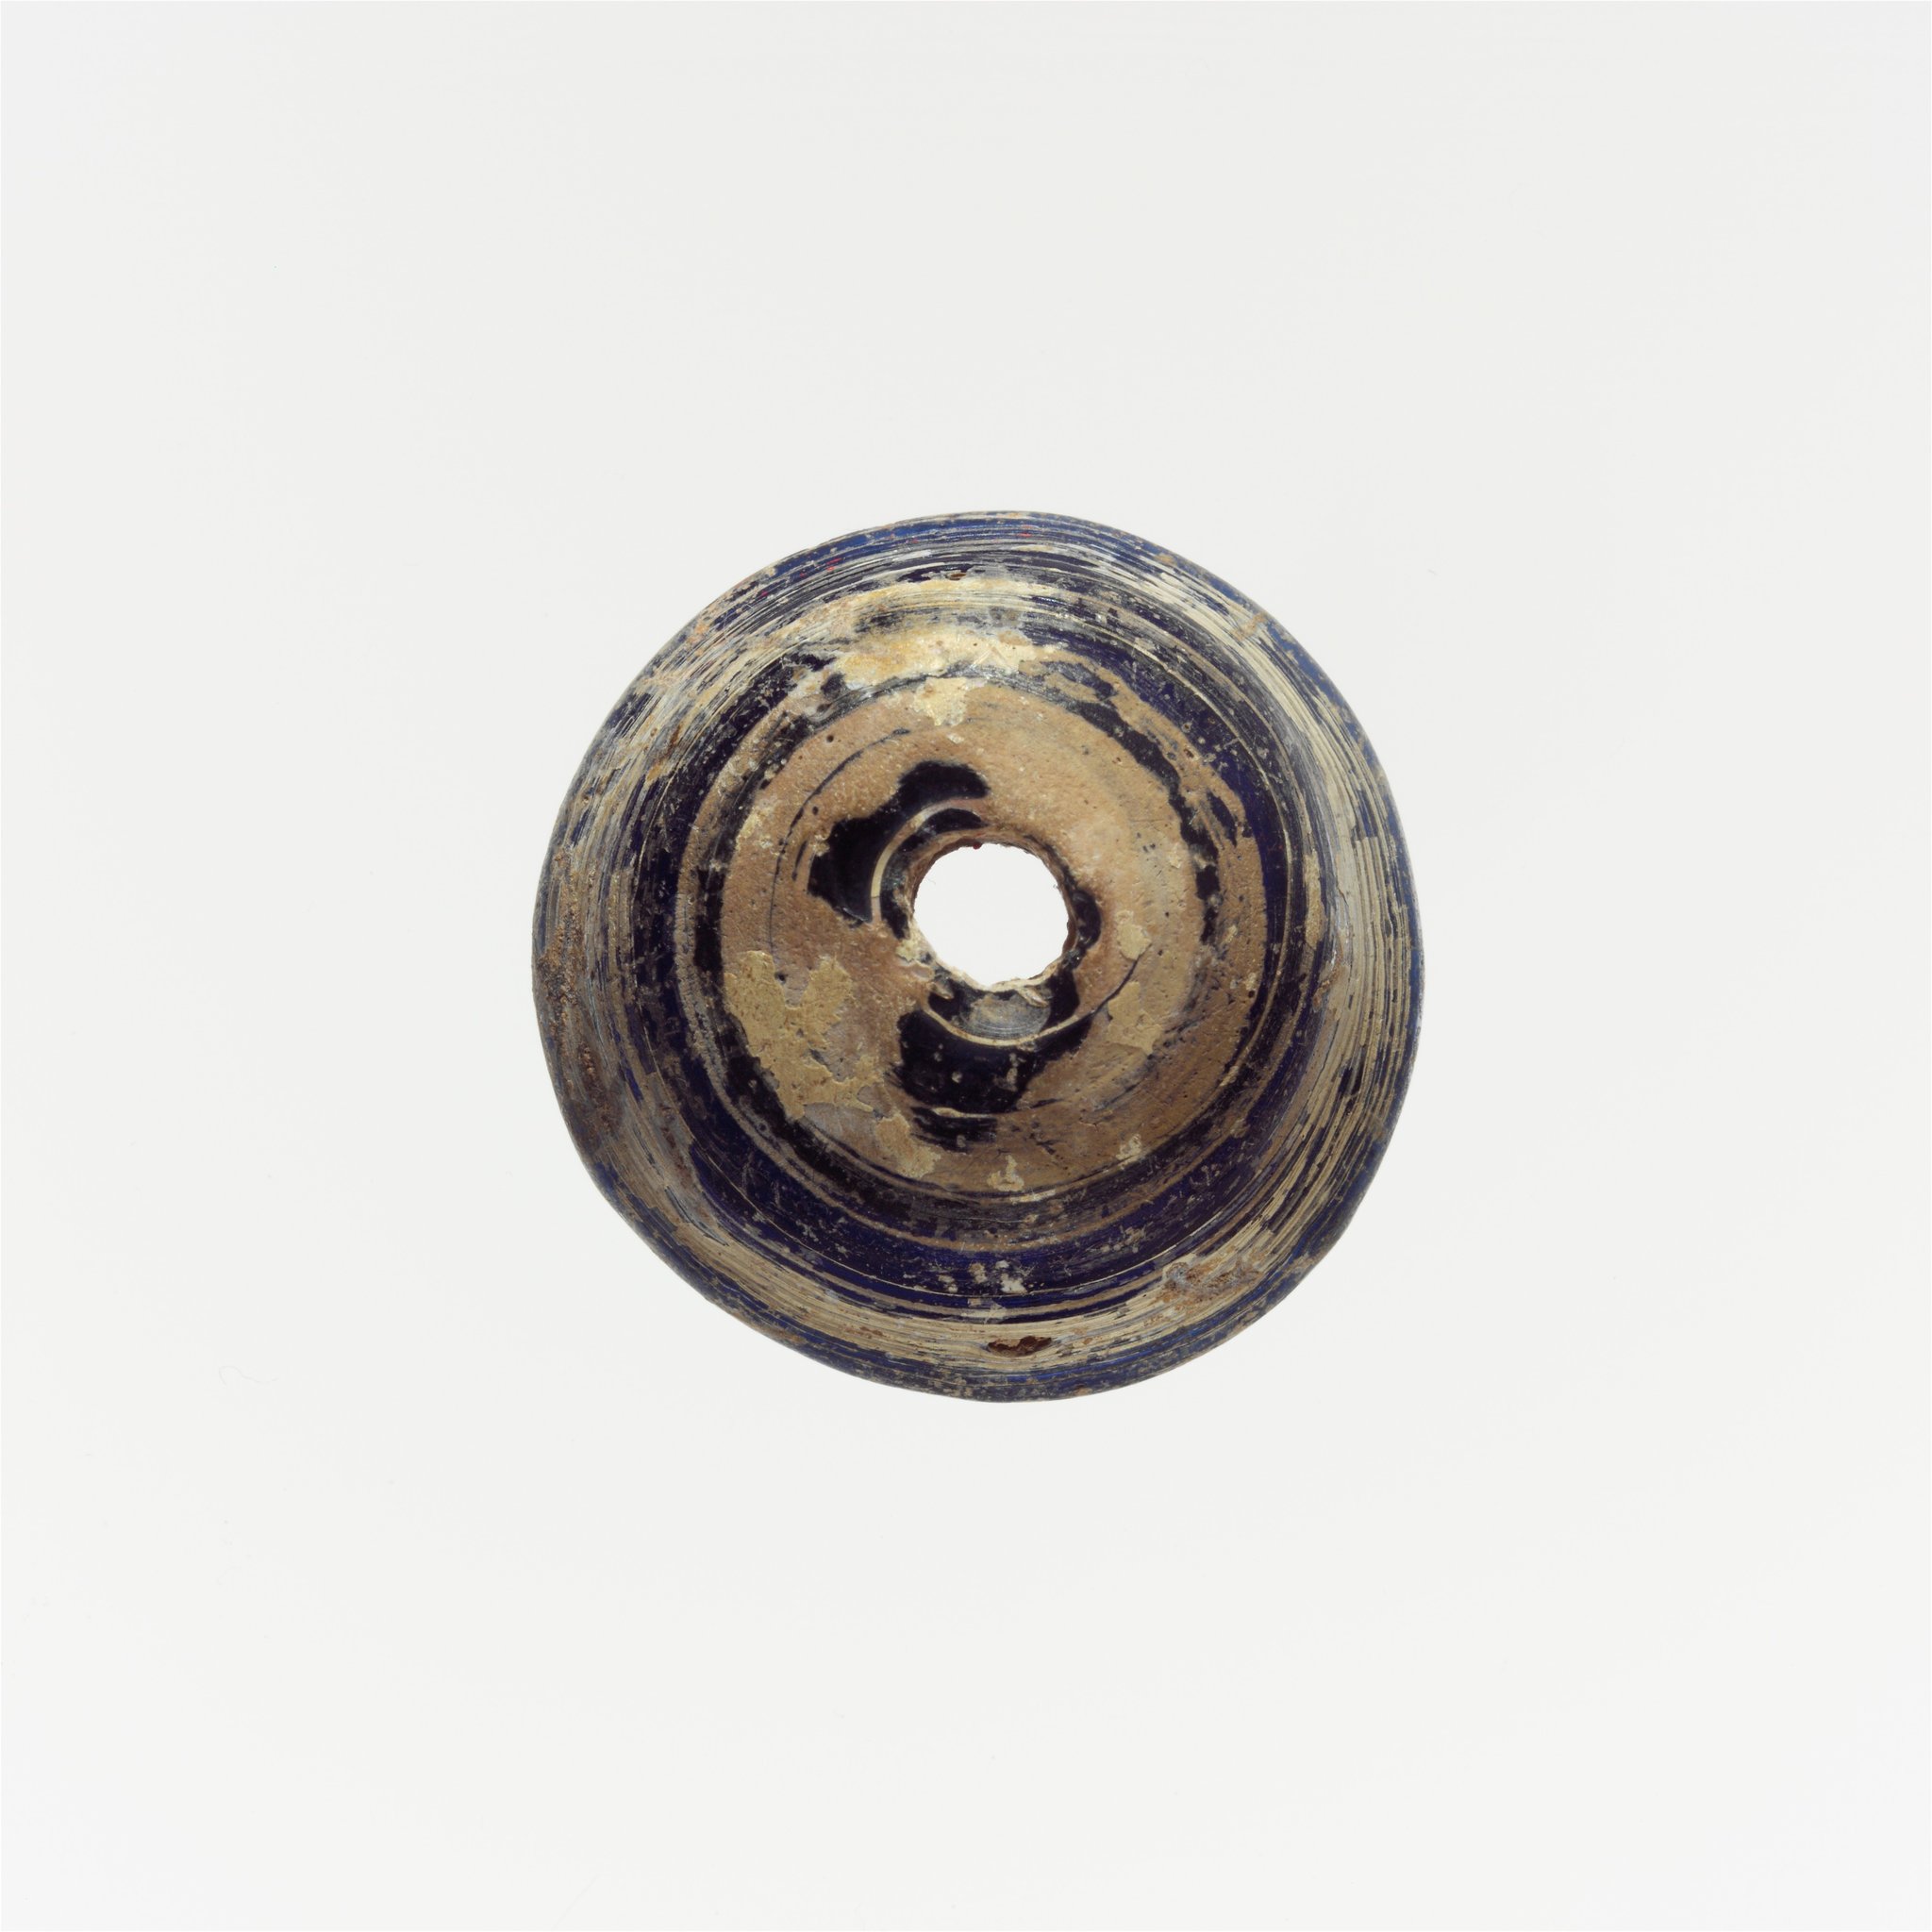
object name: spindle whorl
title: Glass spindle whorl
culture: roman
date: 1-200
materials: glass